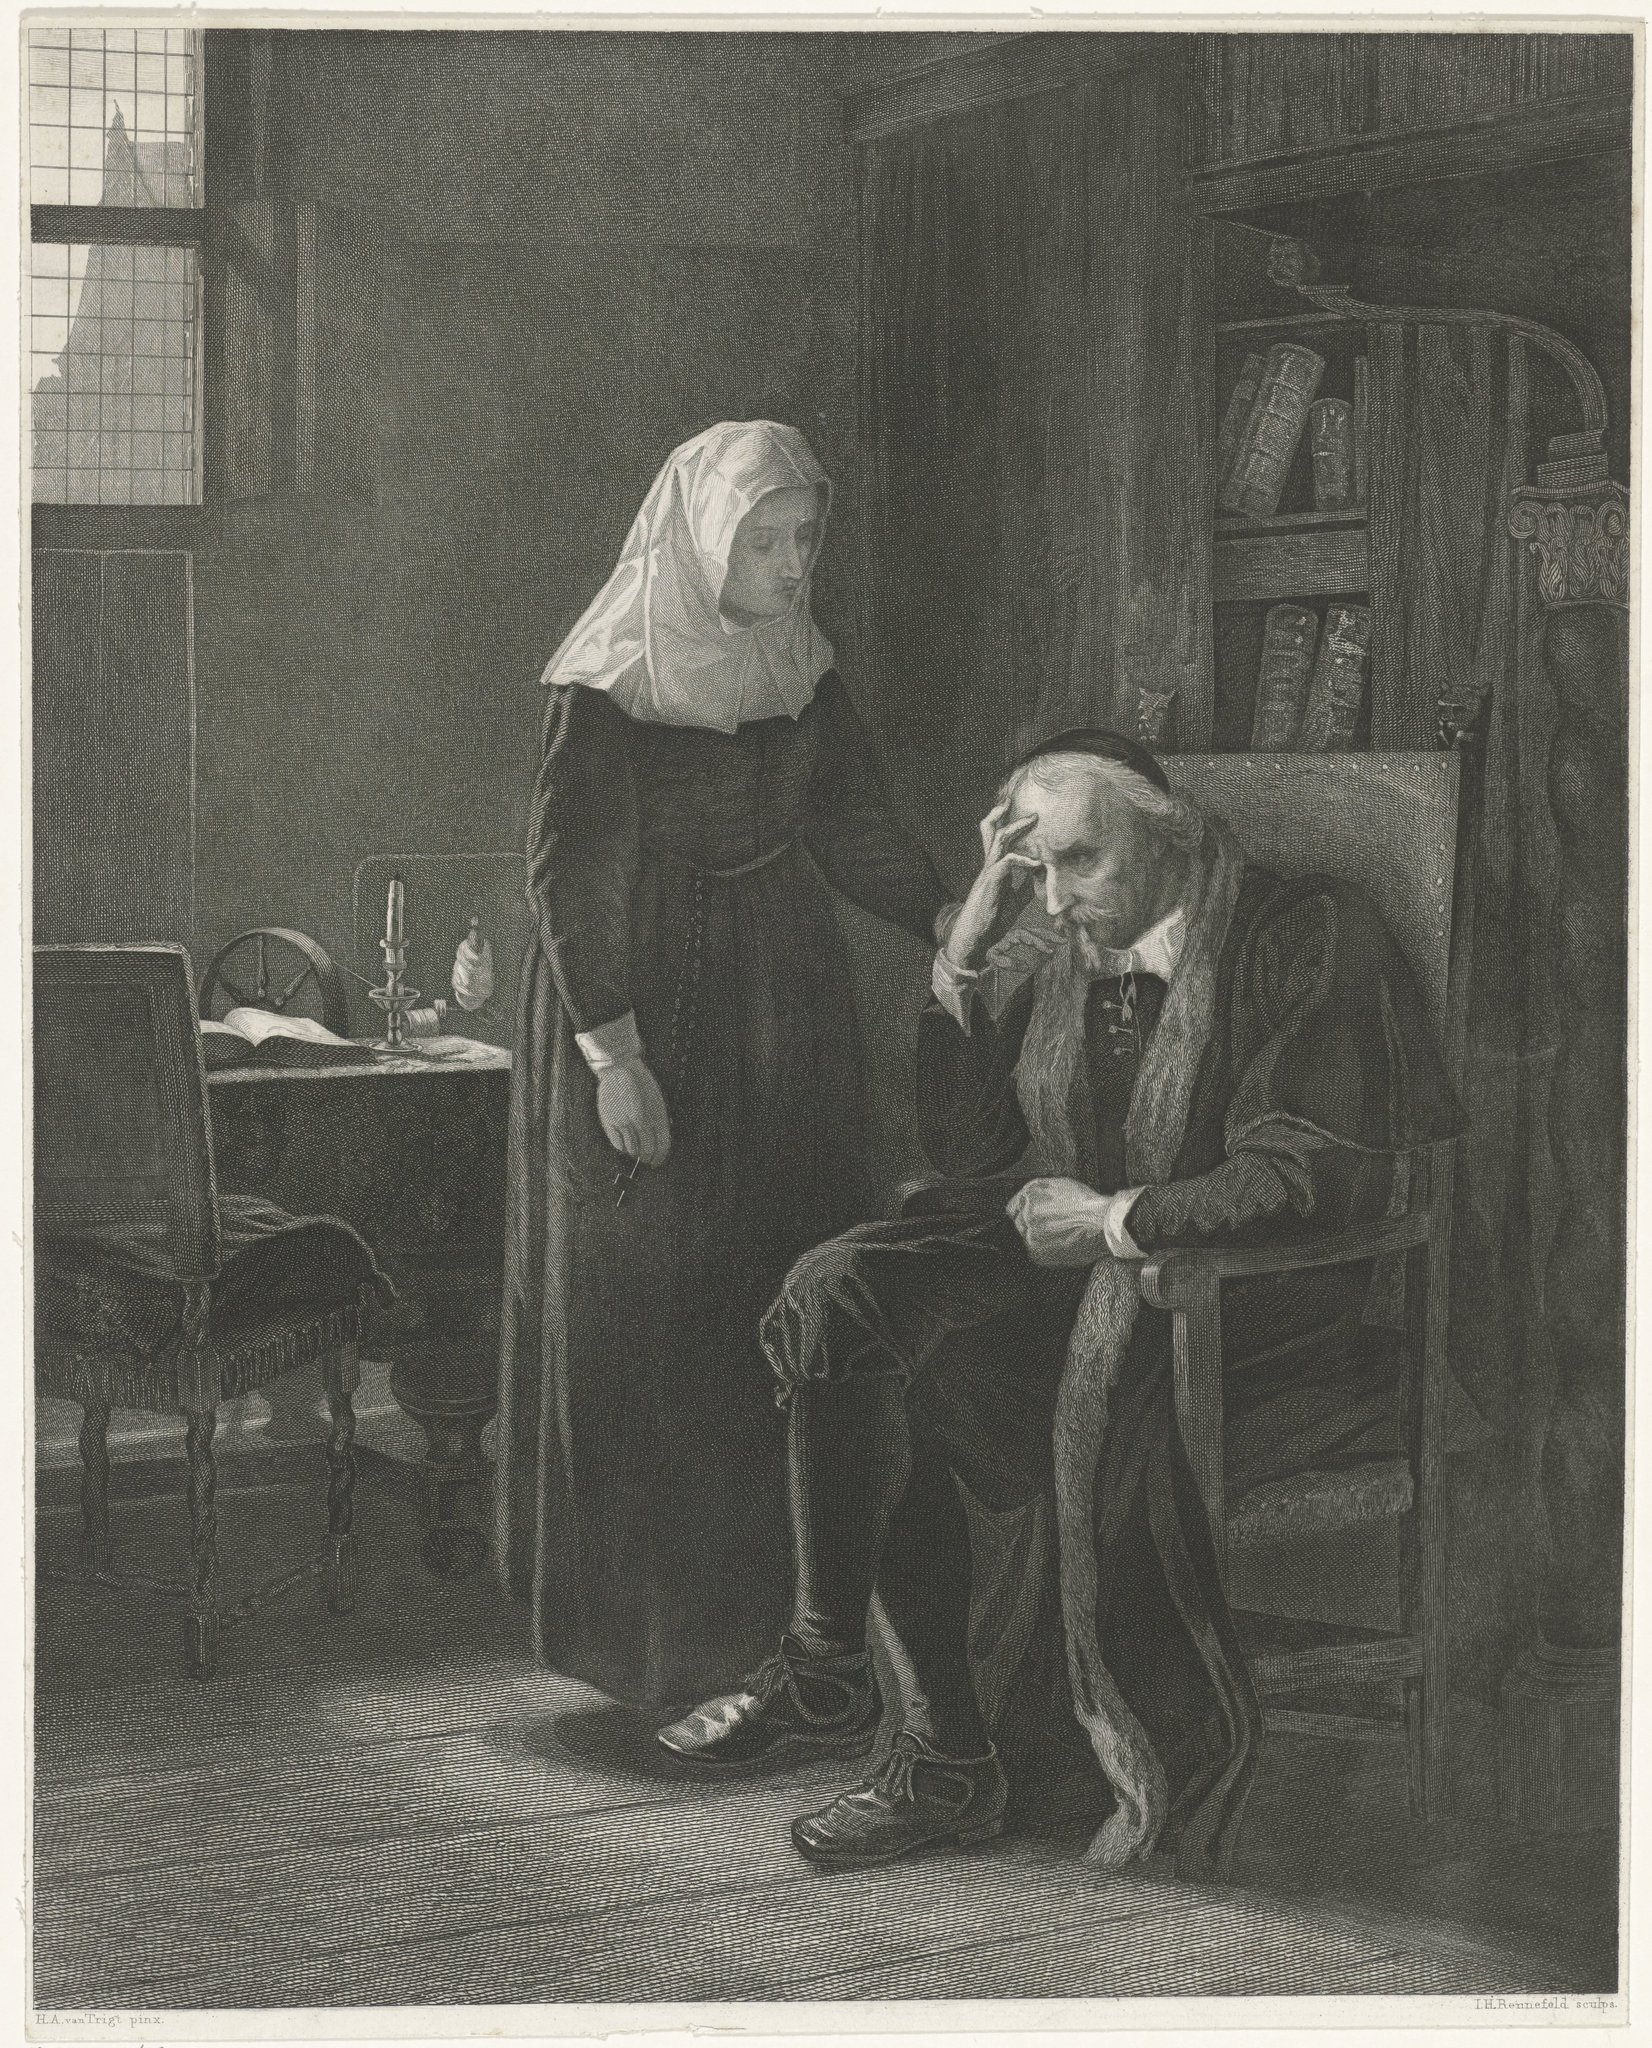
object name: print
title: Cleef 1650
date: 1727-1733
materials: paper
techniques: etching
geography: amsterdam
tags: cleves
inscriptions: collector's mark: Lugt 2228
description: Illustratie uit: Abraham Rademaker, Matthaeus Brouërius van Niedek, Isaac Le Long, Kabinet van Nederlandsche en Kleefsche outheden en (...) voorname stads- en landgebouwen, Willem Barents en Antoni Schoonenburg: Amsterdam, 1727-1733, ill. nr. 285.